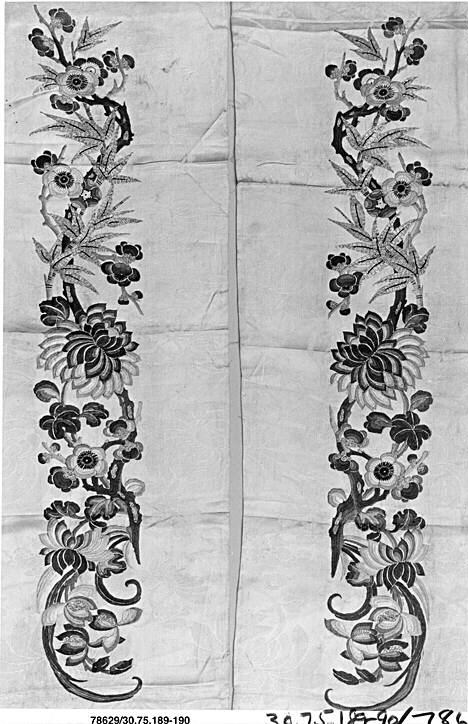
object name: sleeve band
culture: chinese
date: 1801-1900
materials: metal thread, silk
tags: flowers